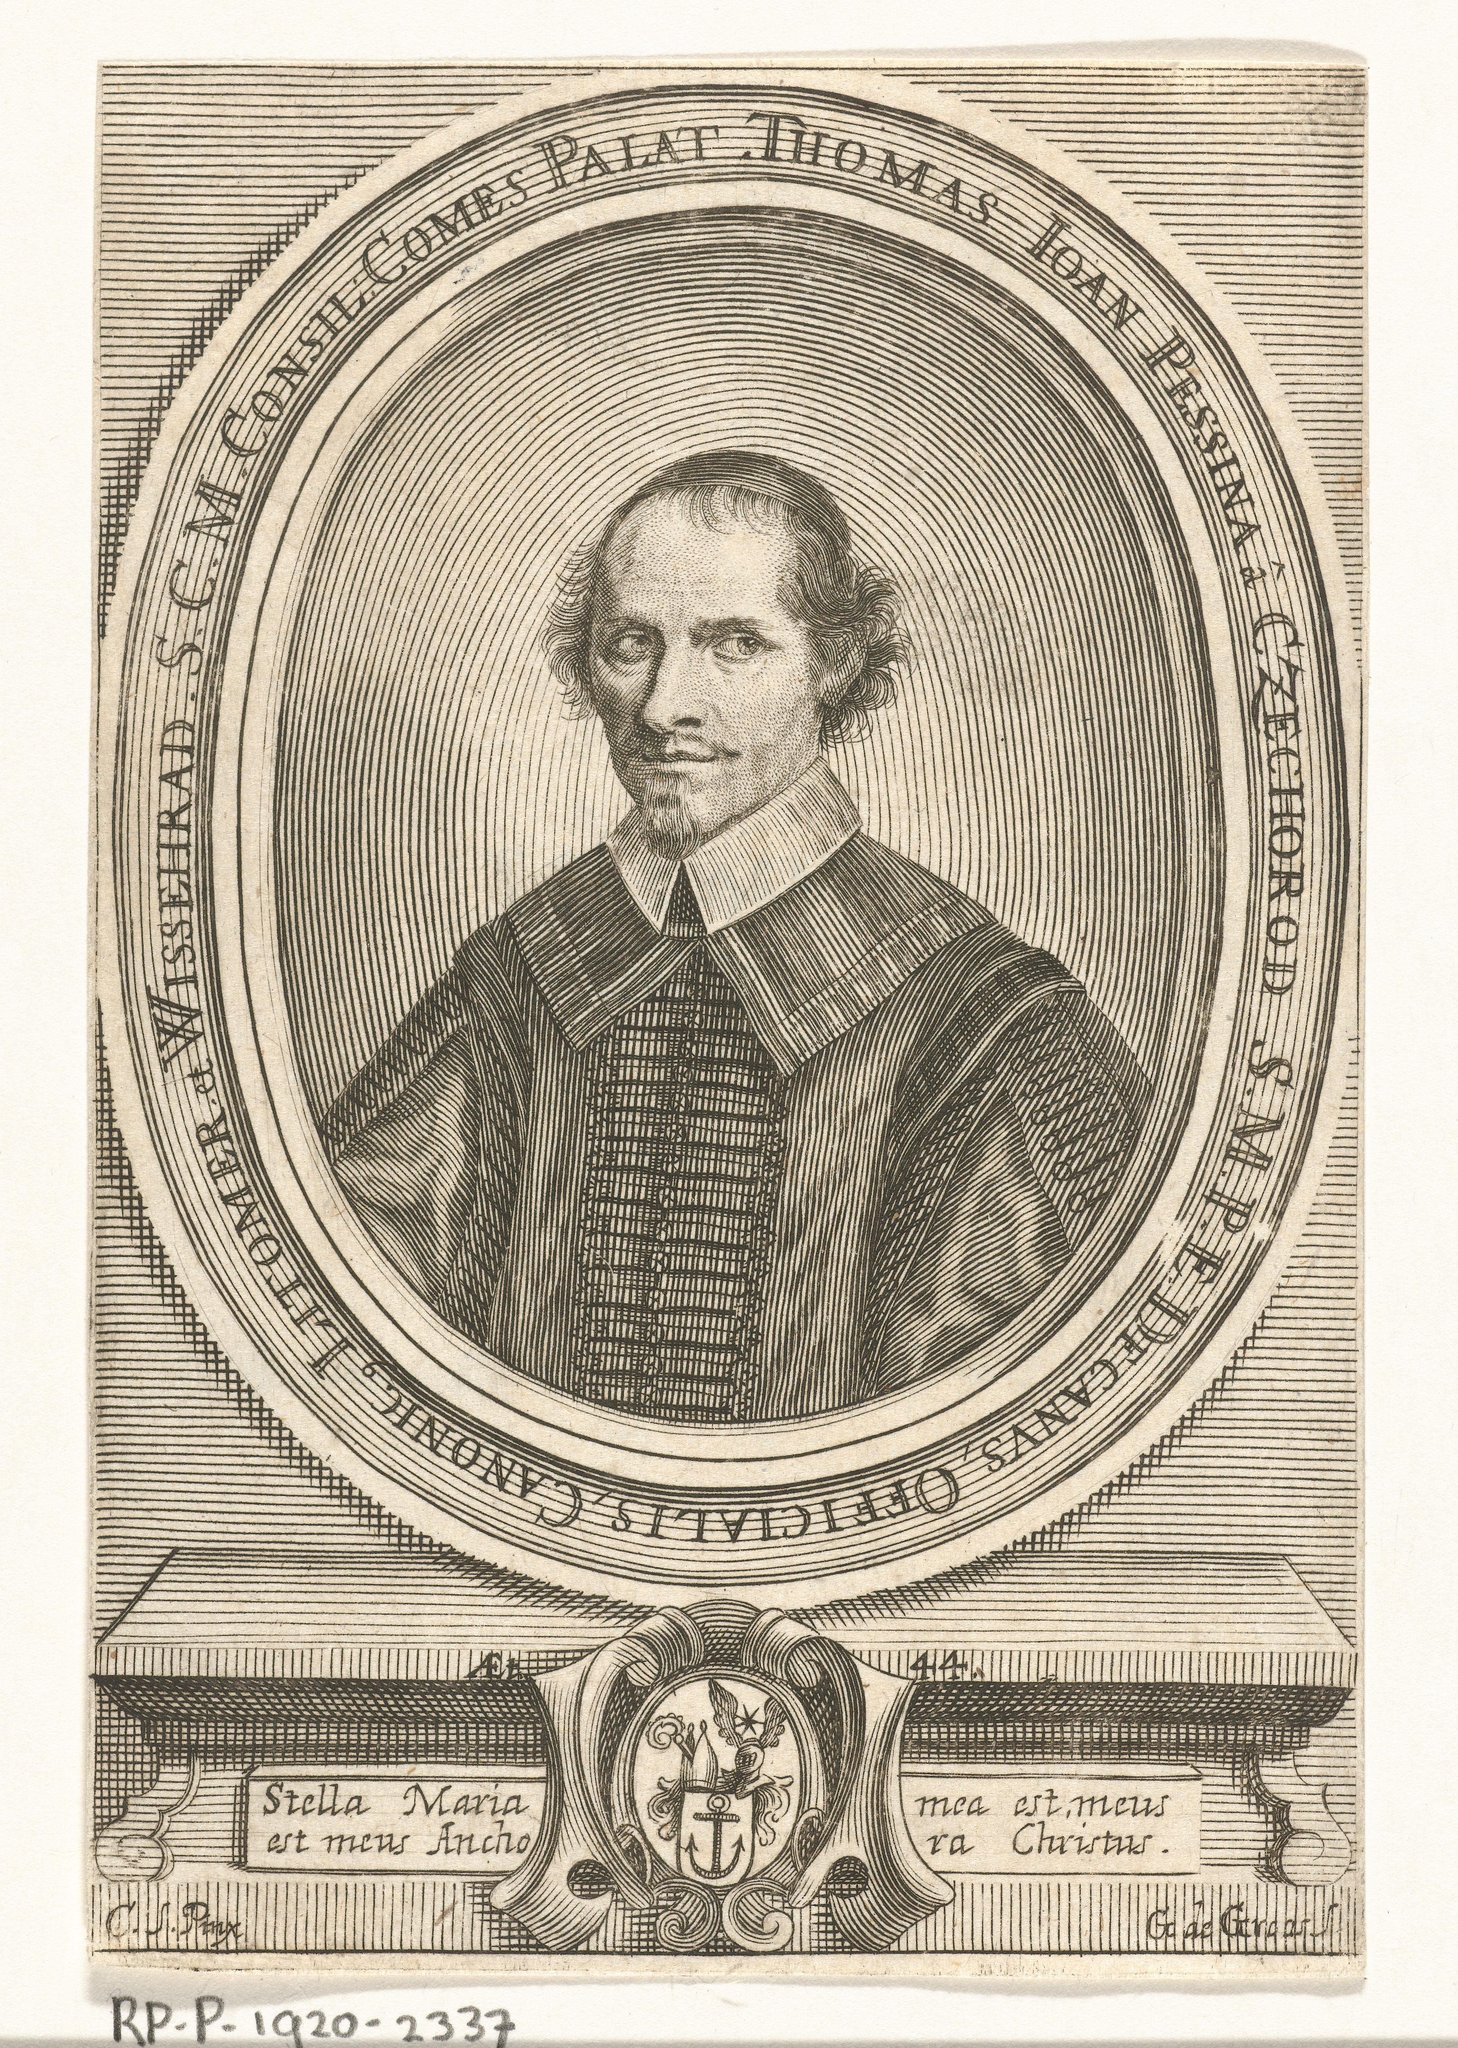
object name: print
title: Portret van Thomas Joannes Pessina de Czechorod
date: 1660-1730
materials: paper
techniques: engraving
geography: prague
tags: theoloog, thomas joannes pessina de czechorod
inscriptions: collector's mark: Lugt 2228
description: Portret van Thomas Joannes Pessina de Czechorod, met kalot. Het portret is gevat in een ovale omlijsting met een randschrift in het Latijn. Op het piëdestal een wapenschild, met daarboven zijn leeftijd, en in het kader twee regels in het Latijn.